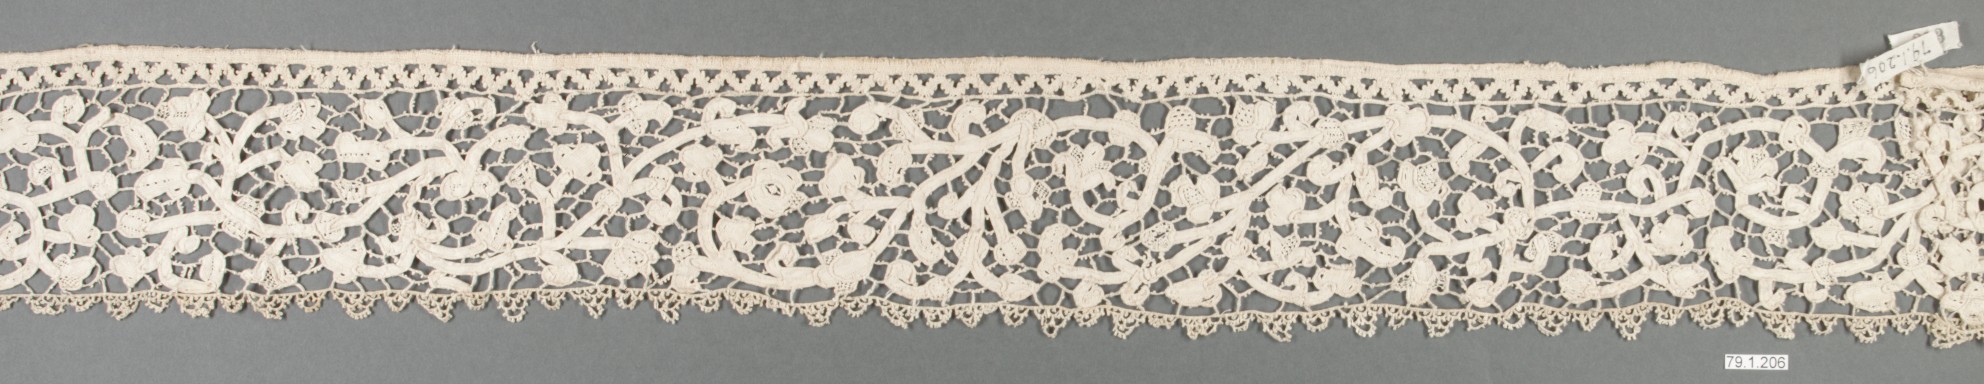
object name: strip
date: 1701-1733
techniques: lace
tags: flowers